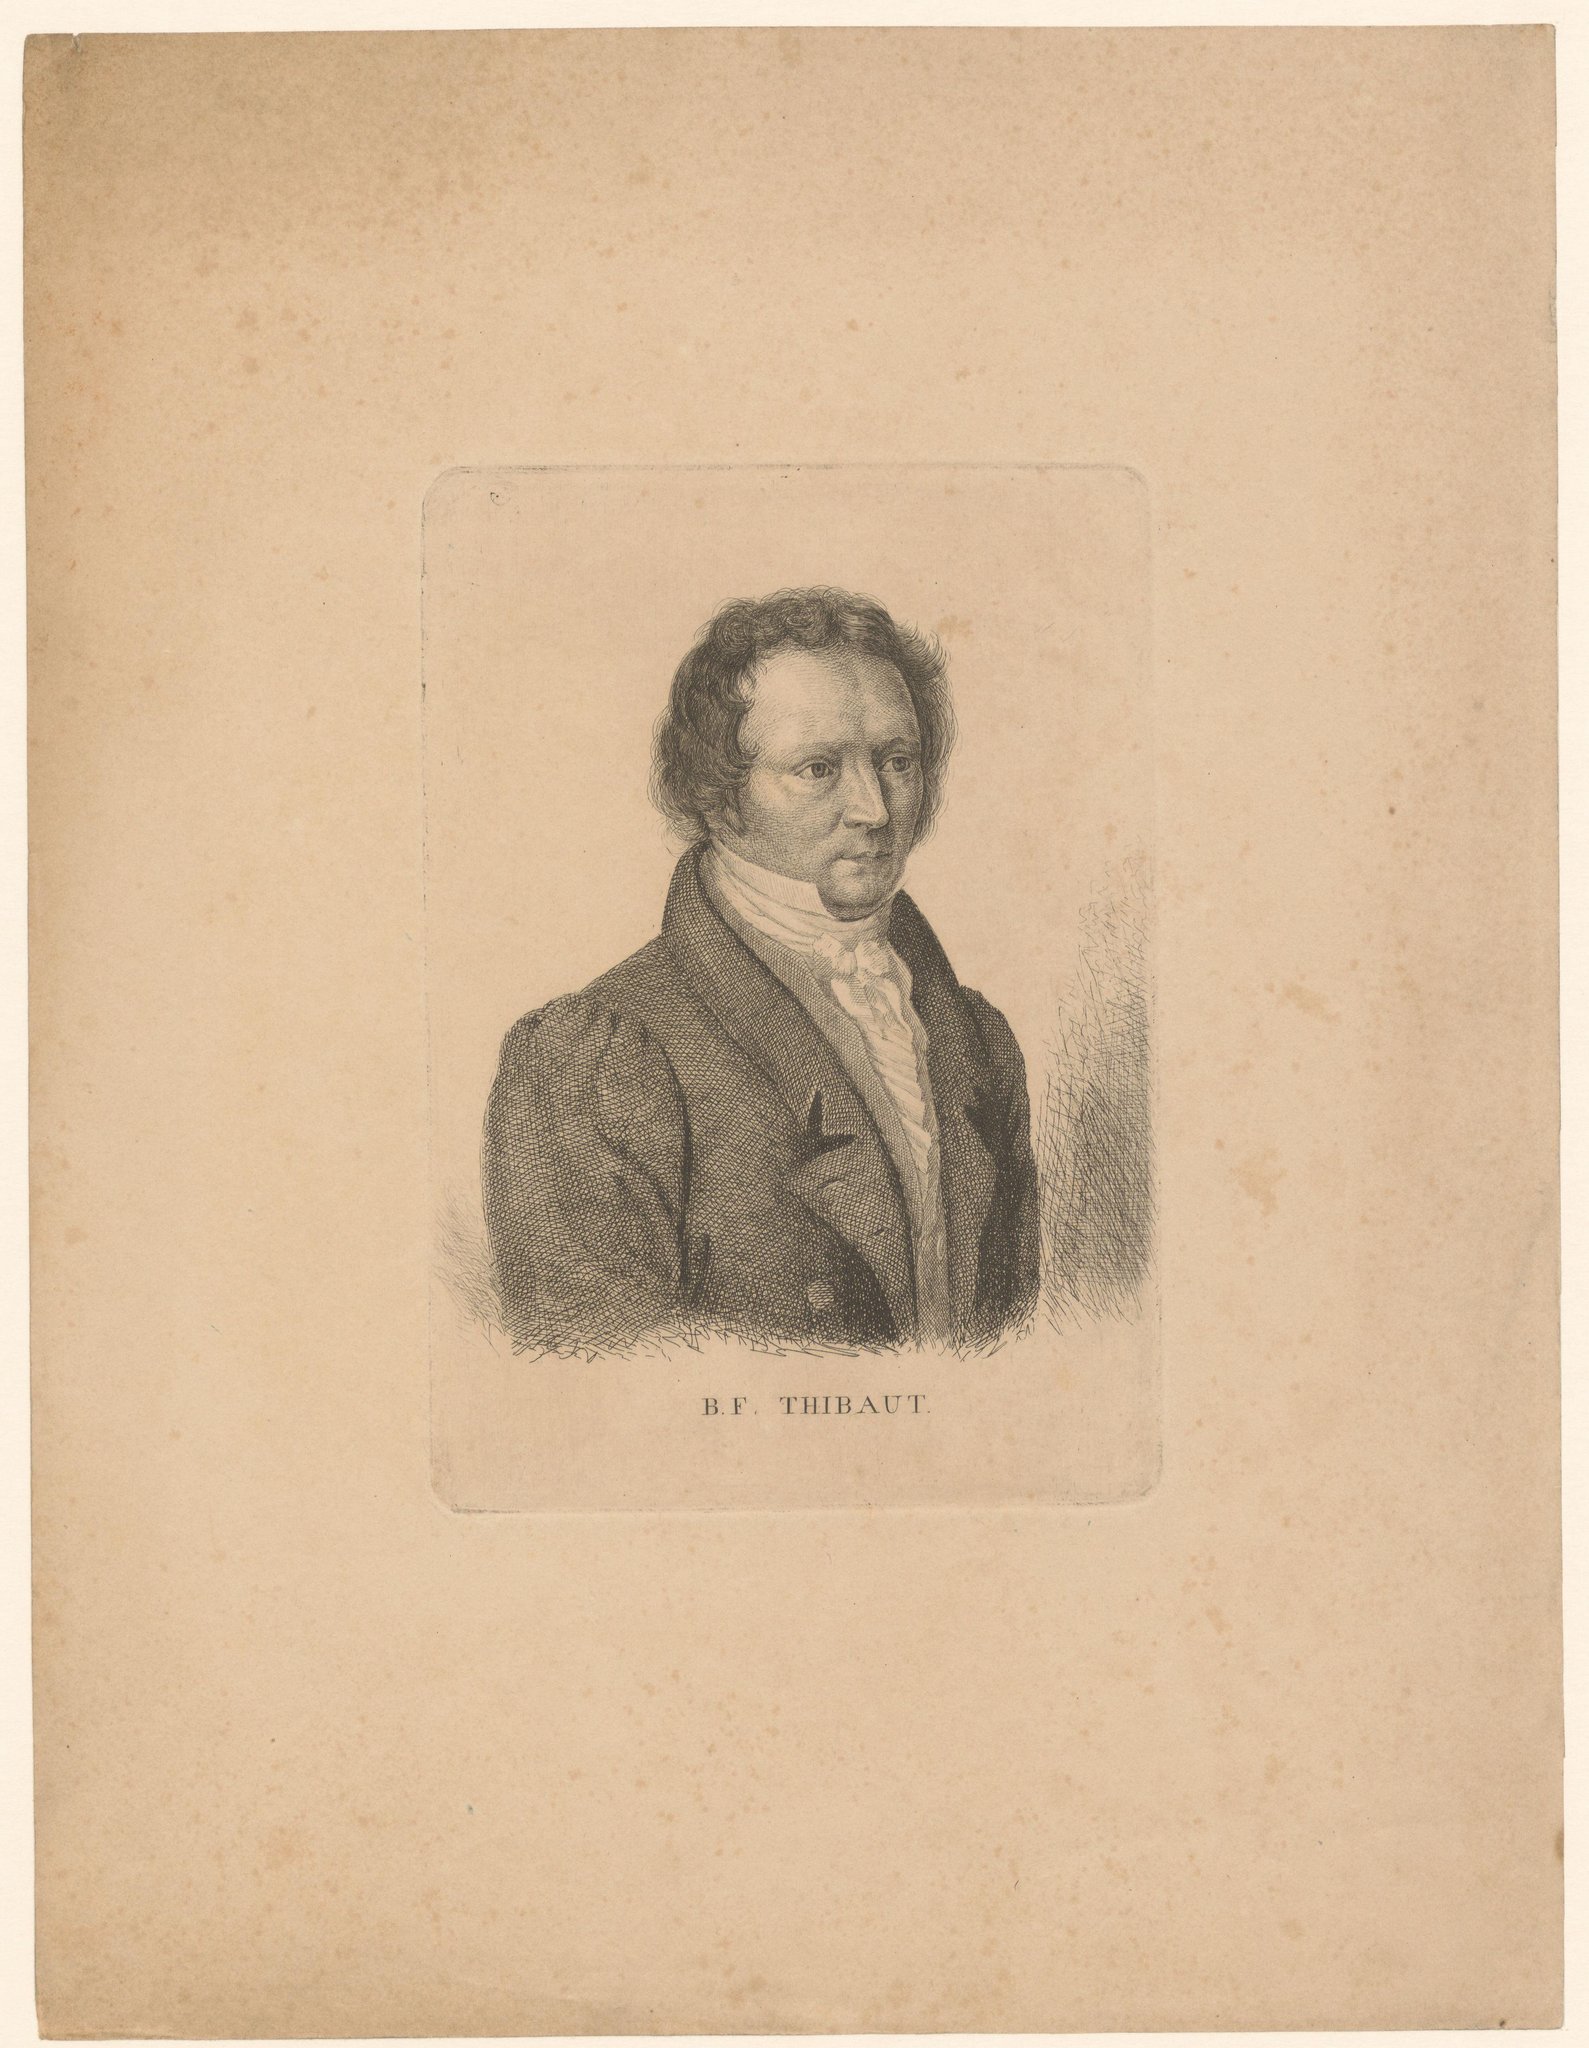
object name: print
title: Portret van Bernhard Friedrich Thibaut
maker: friedrich knolle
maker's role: print maker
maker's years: 1807-1877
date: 1817-1827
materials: paper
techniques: engraving, etching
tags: historical persons, mathematics (+ portrait of scholar, scientist)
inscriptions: collector's mark: Lugt 2228